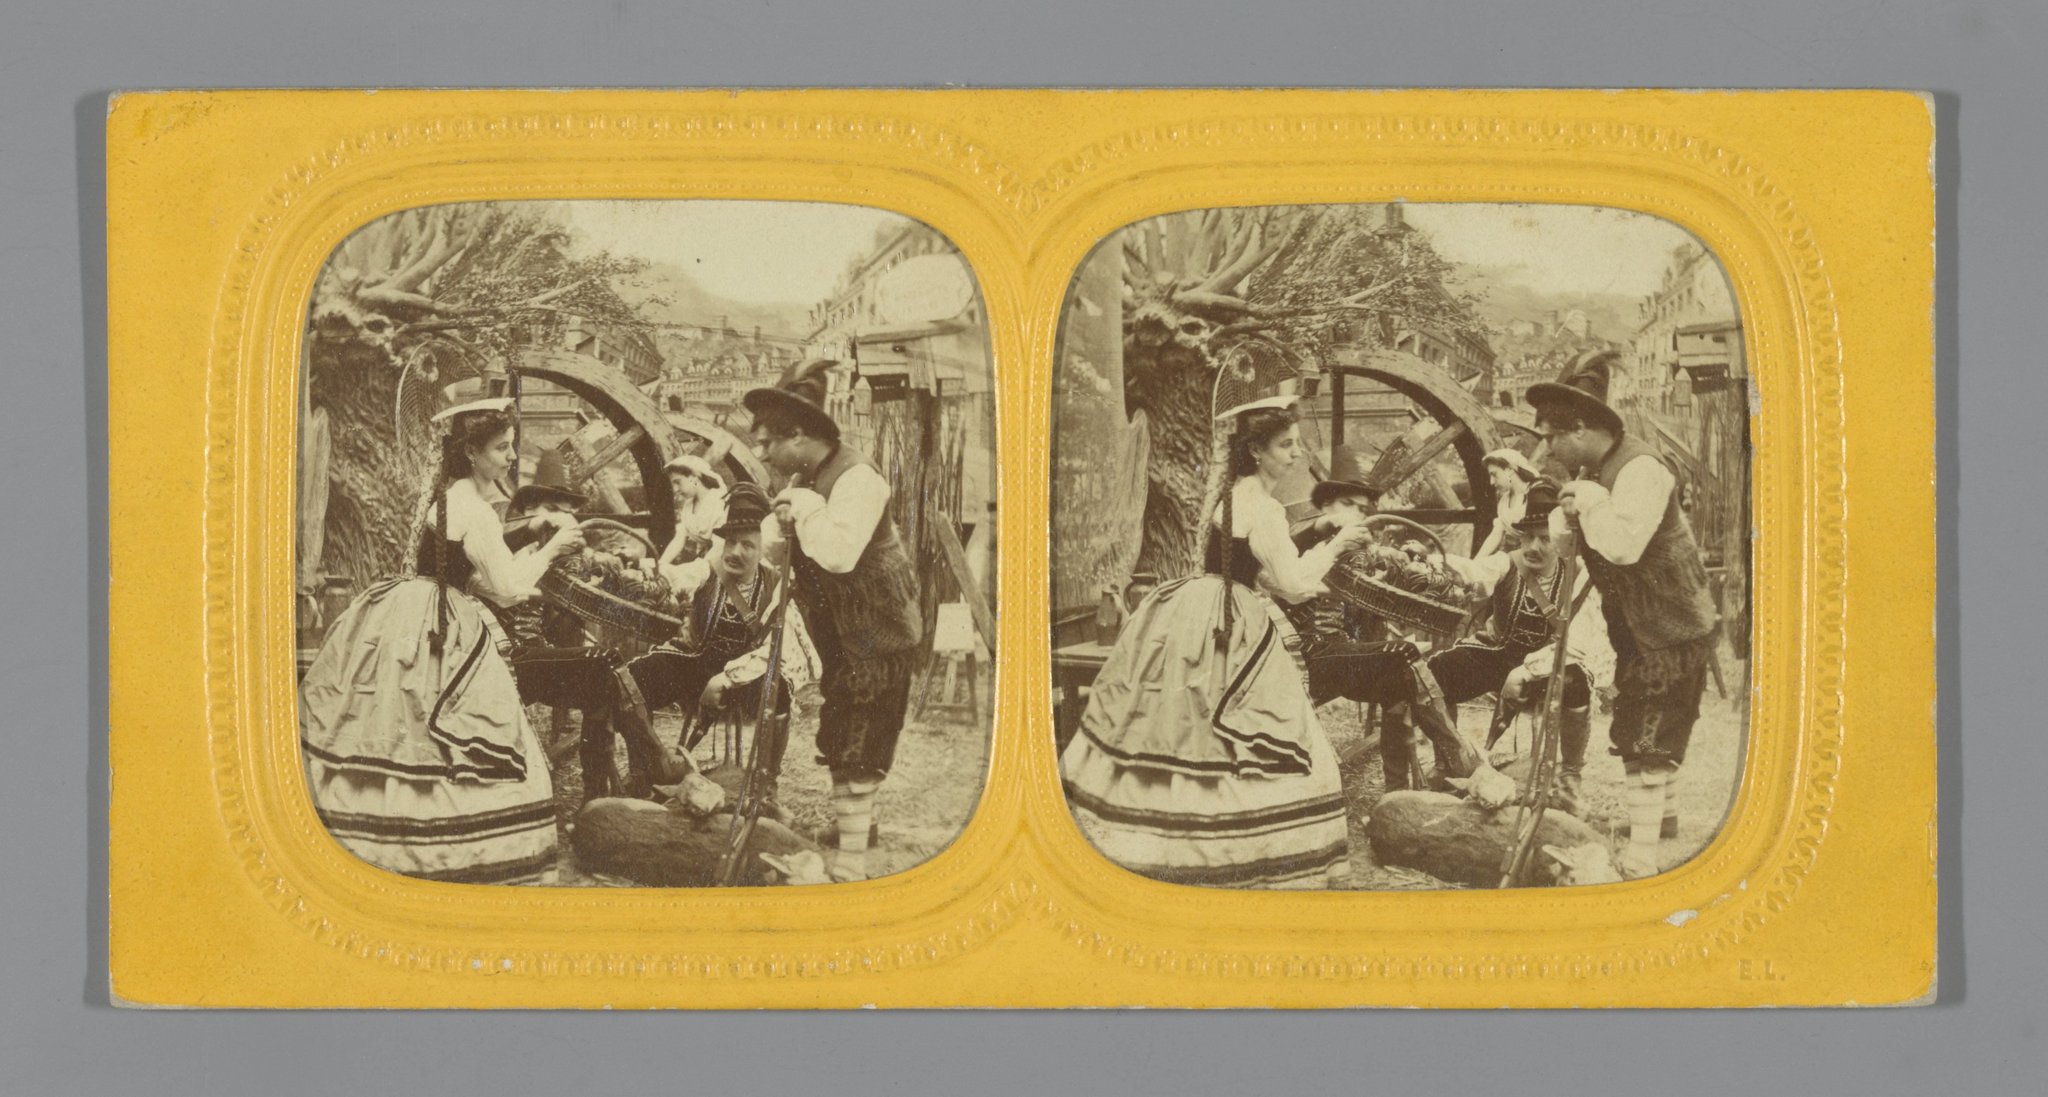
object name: tissue stereograph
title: Mensen in klederdracht in bergdorp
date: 1855-1875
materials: cardboard, paper, photographic support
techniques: albumen print, cutting, hand coloring, perforating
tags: folk costume, regional costume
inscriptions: number: ‘5’, number: ‘60’